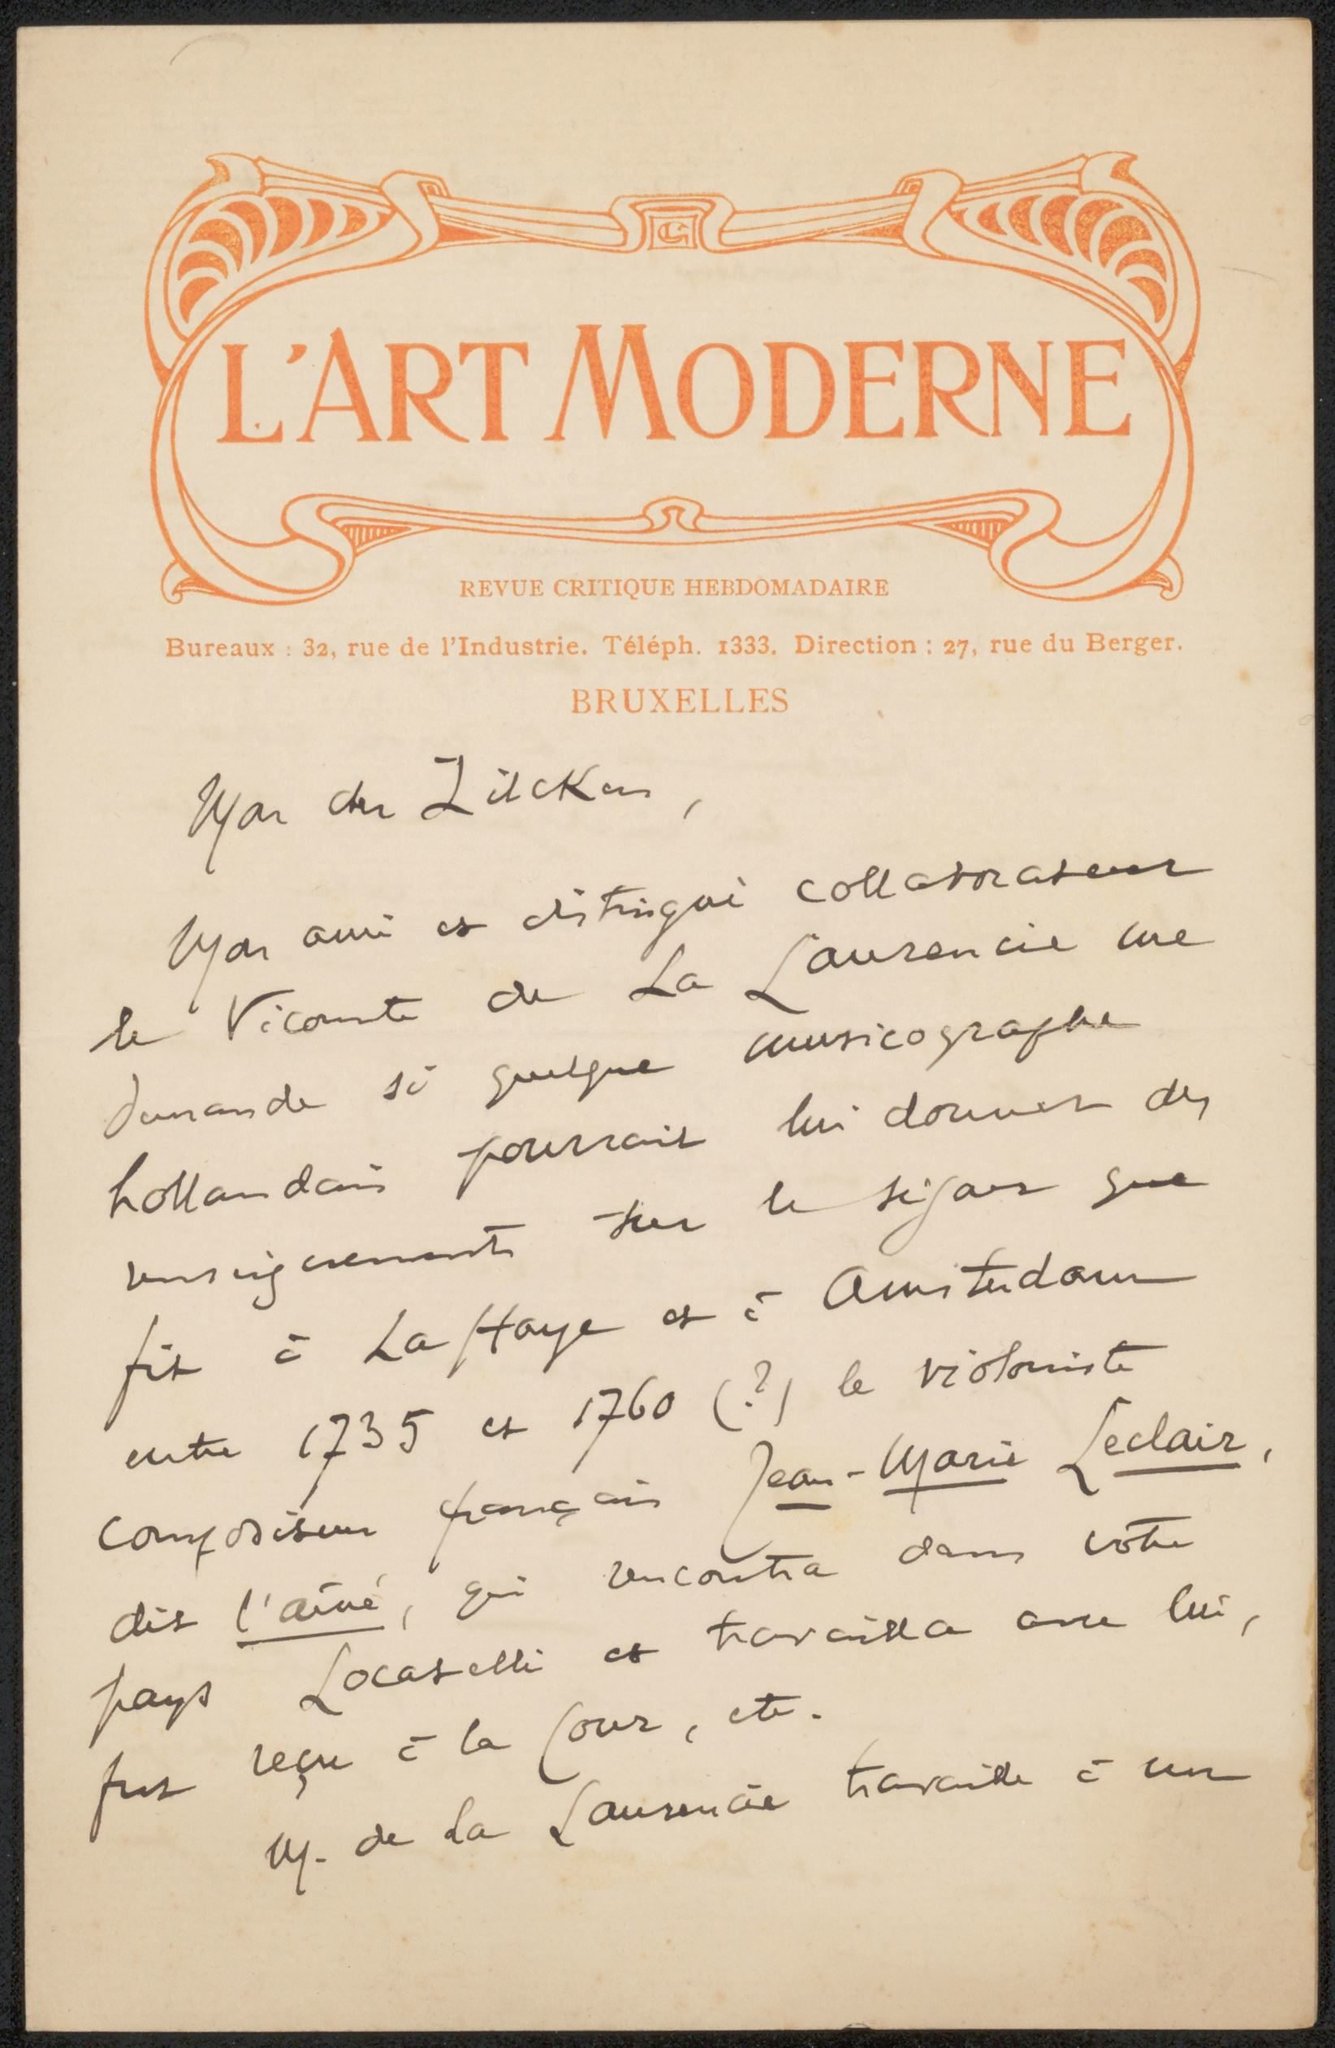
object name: letter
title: Brief aan Philip Zilcken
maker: octave maus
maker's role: painter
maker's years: 1856-1919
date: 1904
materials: ink, paper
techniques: pen, printing, writing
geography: brussels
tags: lyon, paris, the hague, painter, philip zilcken, music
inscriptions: collector's mark: ‘RPK’, watermark